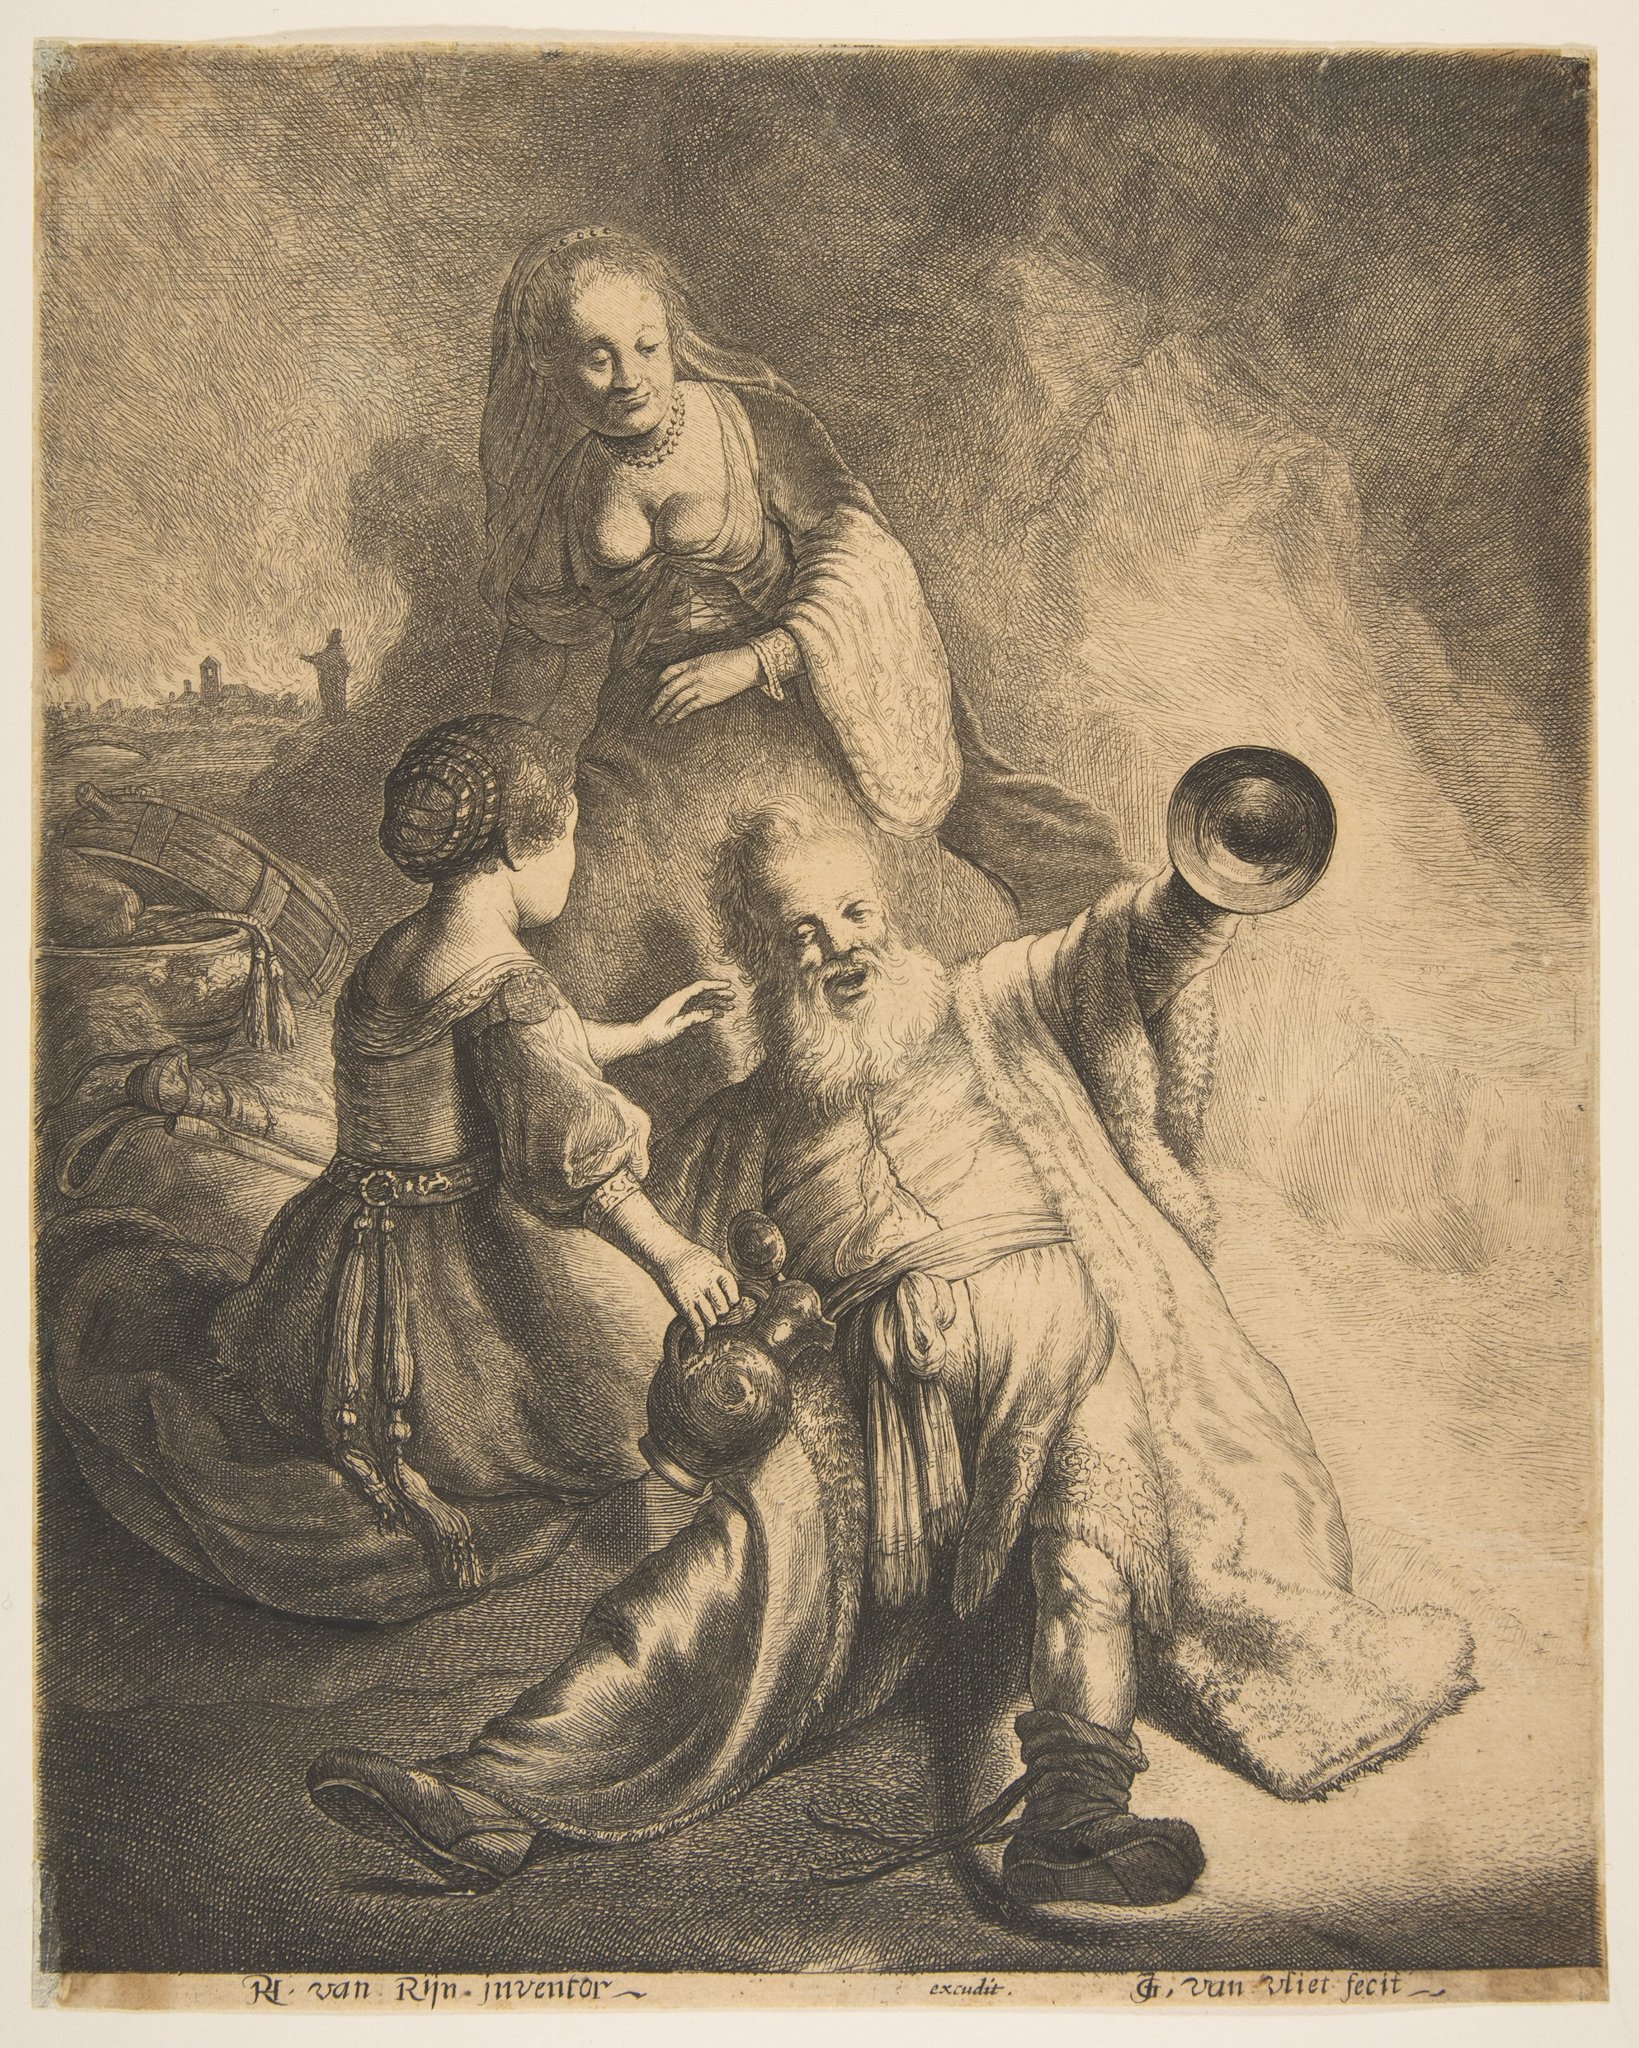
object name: print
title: Lot and his Daughters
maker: jan georg (joris) van vliet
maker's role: artist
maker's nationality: dutch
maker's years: 1610-1635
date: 1620-1640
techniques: etching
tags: girls,men,women